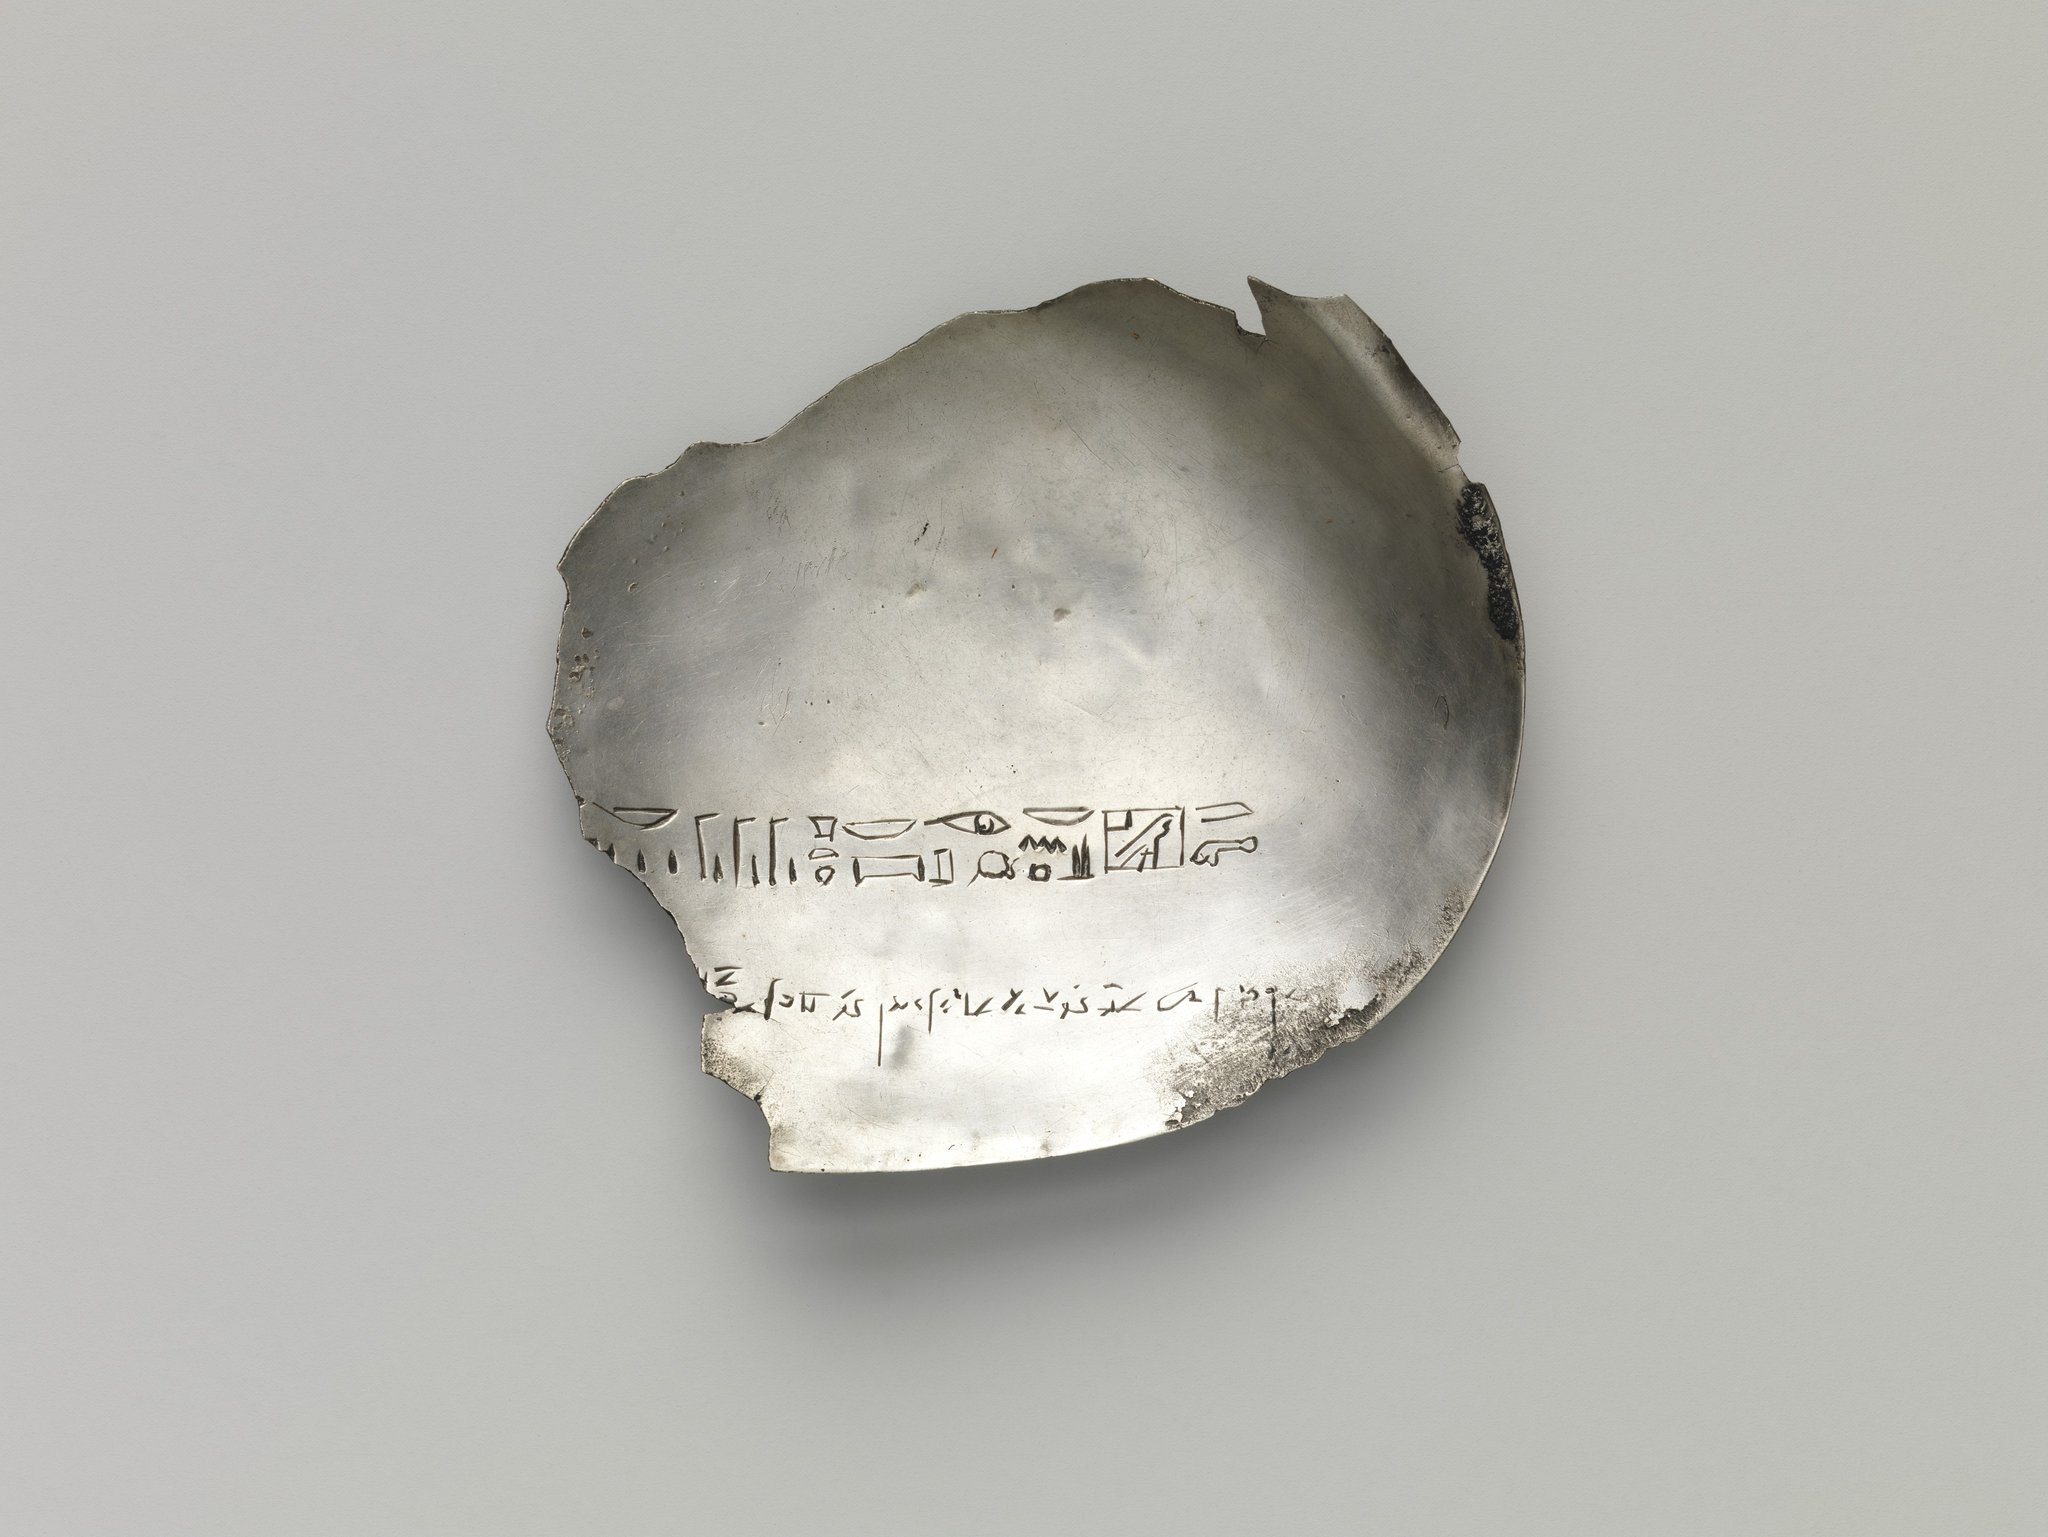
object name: dish, hathor, peteharsomtous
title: Fragmentary dish with inscription for Hathor from Peteharsomtous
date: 332-330 BCE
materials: silver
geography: northern upper egypt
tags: hieroglyphs